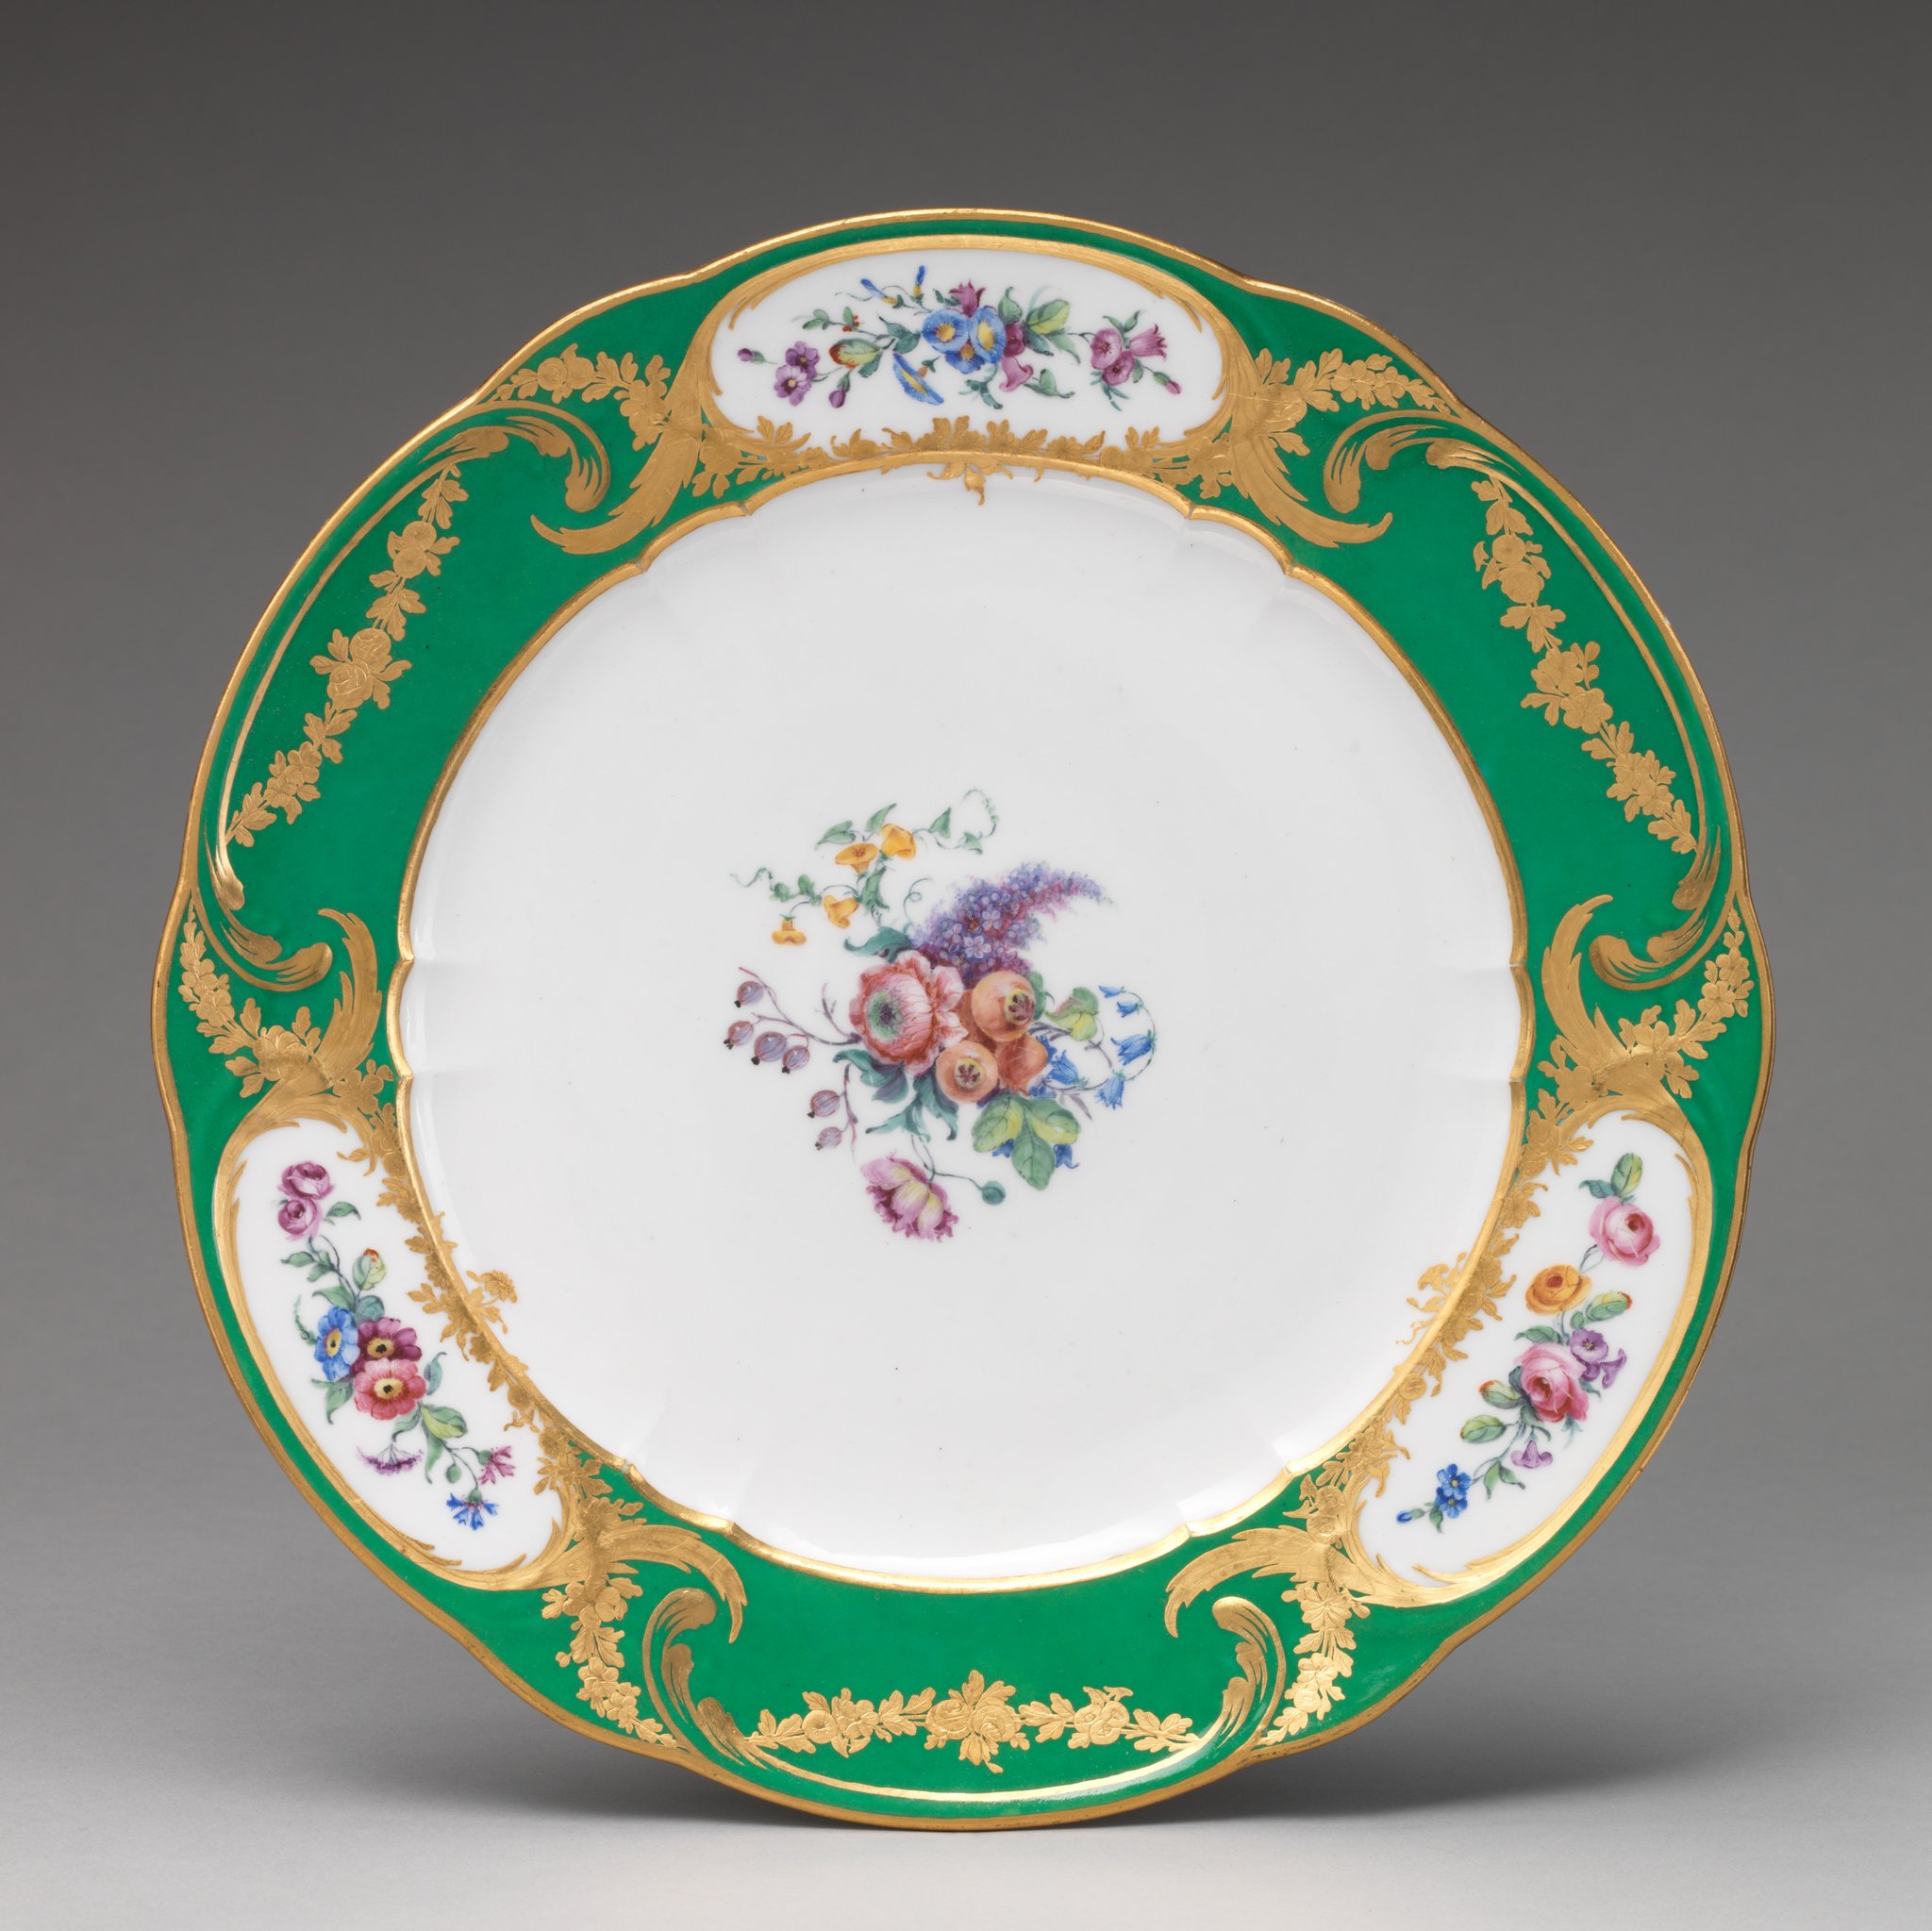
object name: plate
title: Plate (Assiette à palmes) (1 of 102) (part of a service)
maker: sèvres manufactory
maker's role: manufactory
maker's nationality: french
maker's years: 1740-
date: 1780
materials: soft paste porcelain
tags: flowers